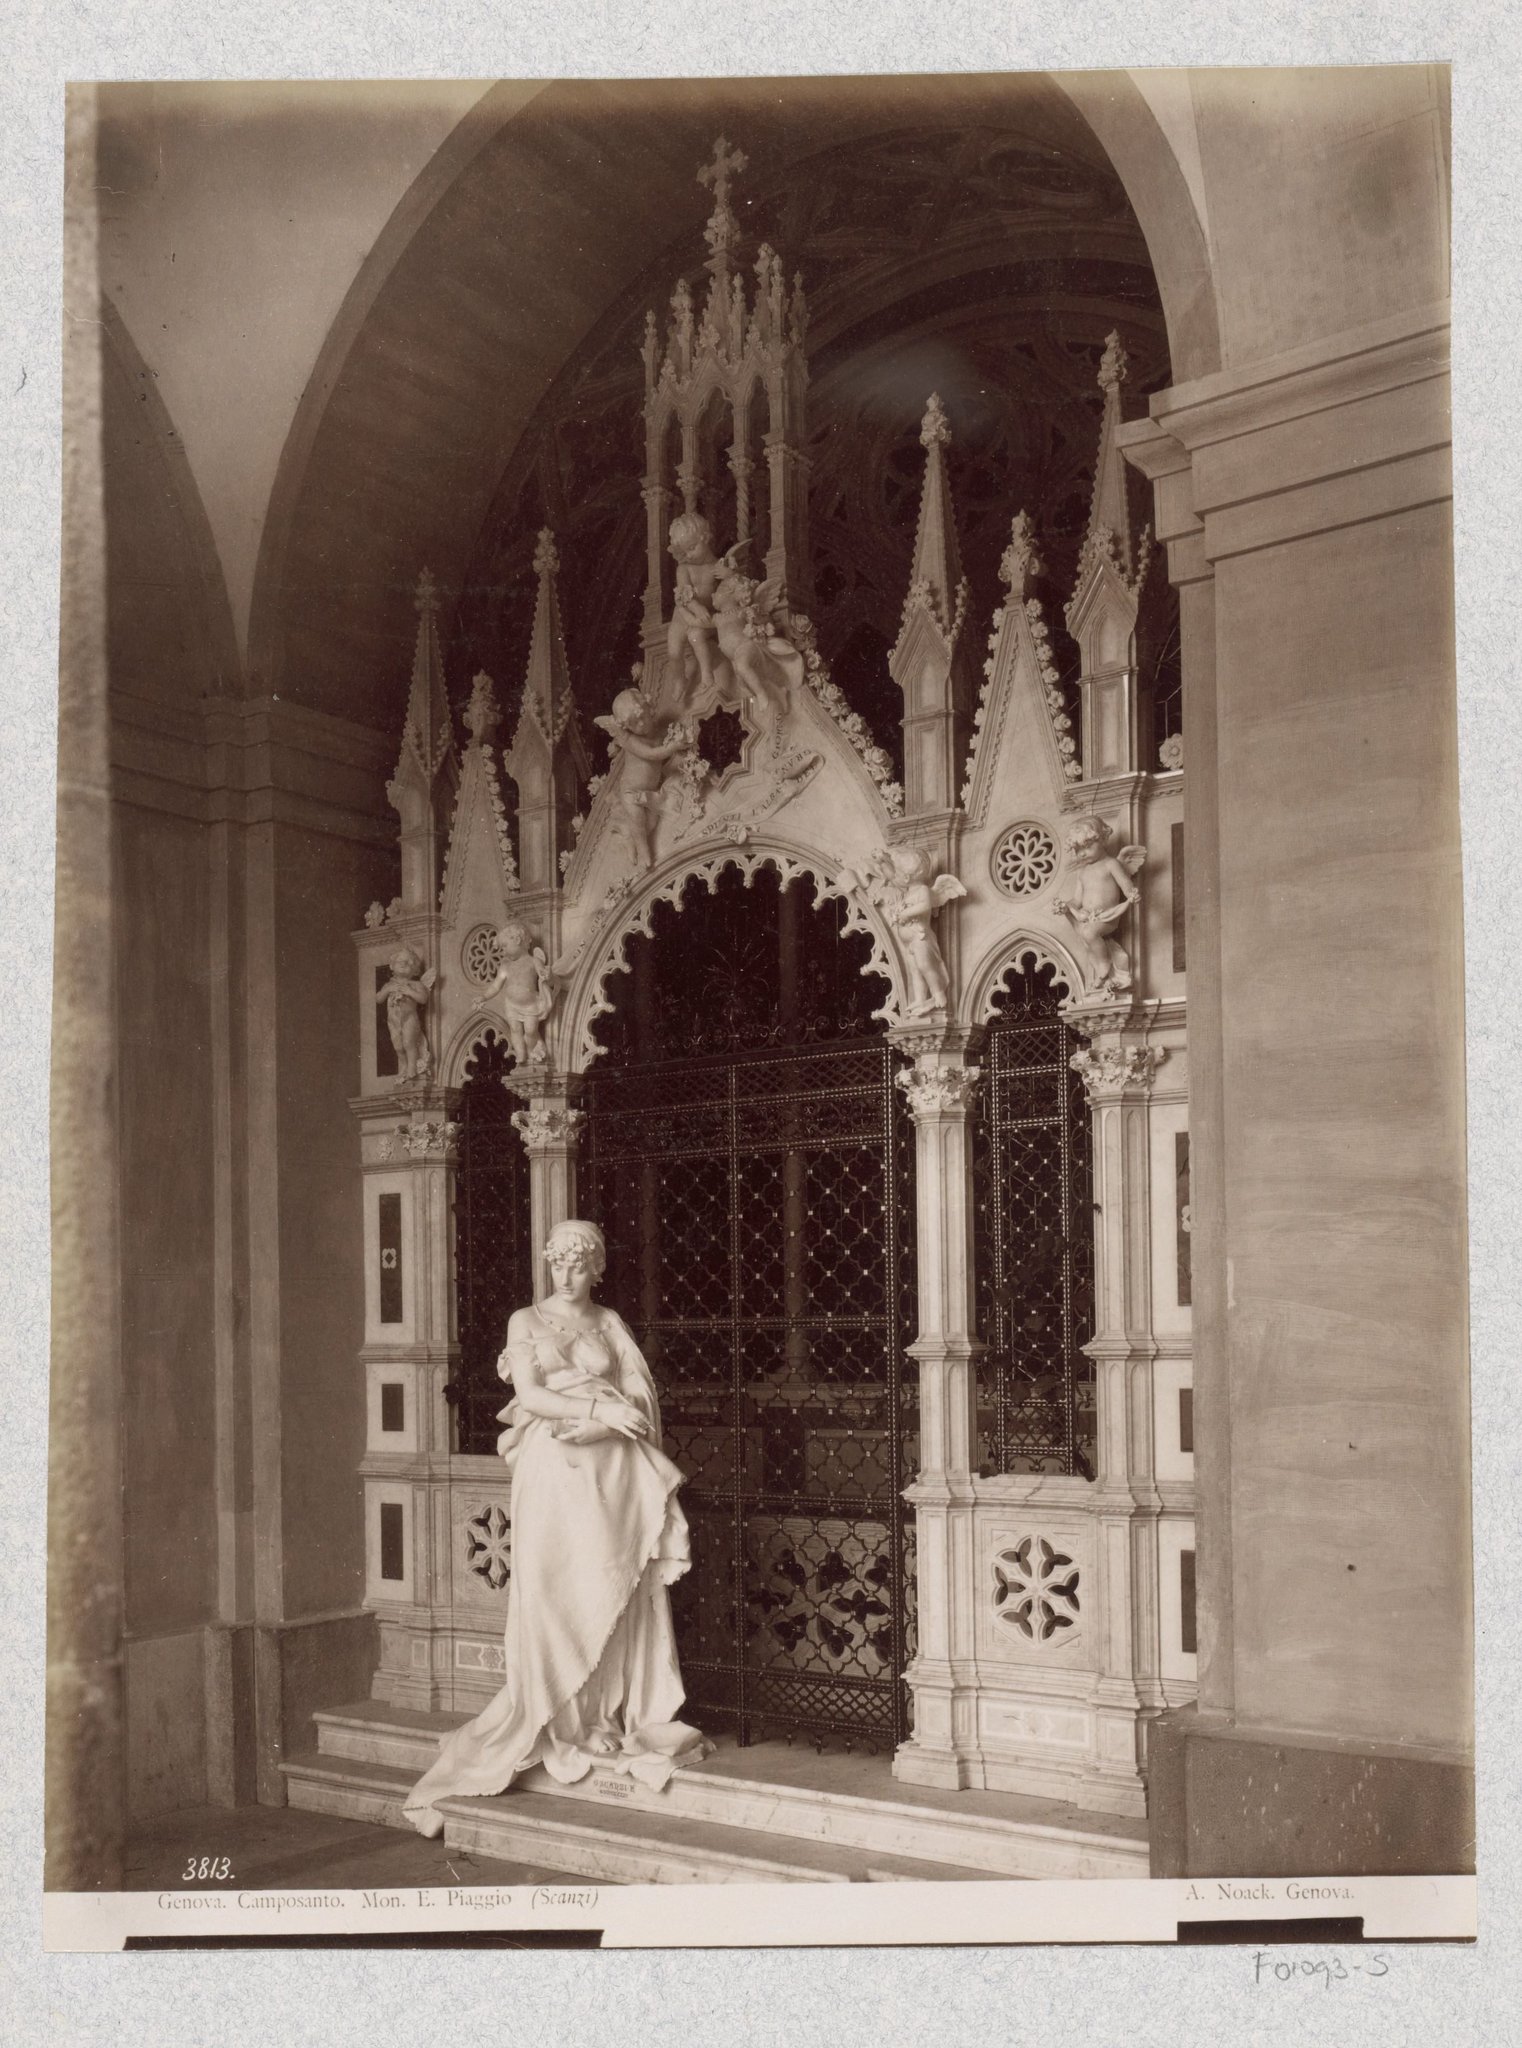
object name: photograph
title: Genova. Camposanto. Mon. E. Piaggio (Scanzi)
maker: alfredo noack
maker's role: fotograaf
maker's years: 1833-1895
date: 1870-1890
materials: paper, photographic support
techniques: albumen print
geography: genoa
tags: grave, tomb, monument, statue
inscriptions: negative number: ‘3813’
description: Onderdeel van Reisalbum met foto's van bezienswaardigheden in Genua, Florence en Venetië.